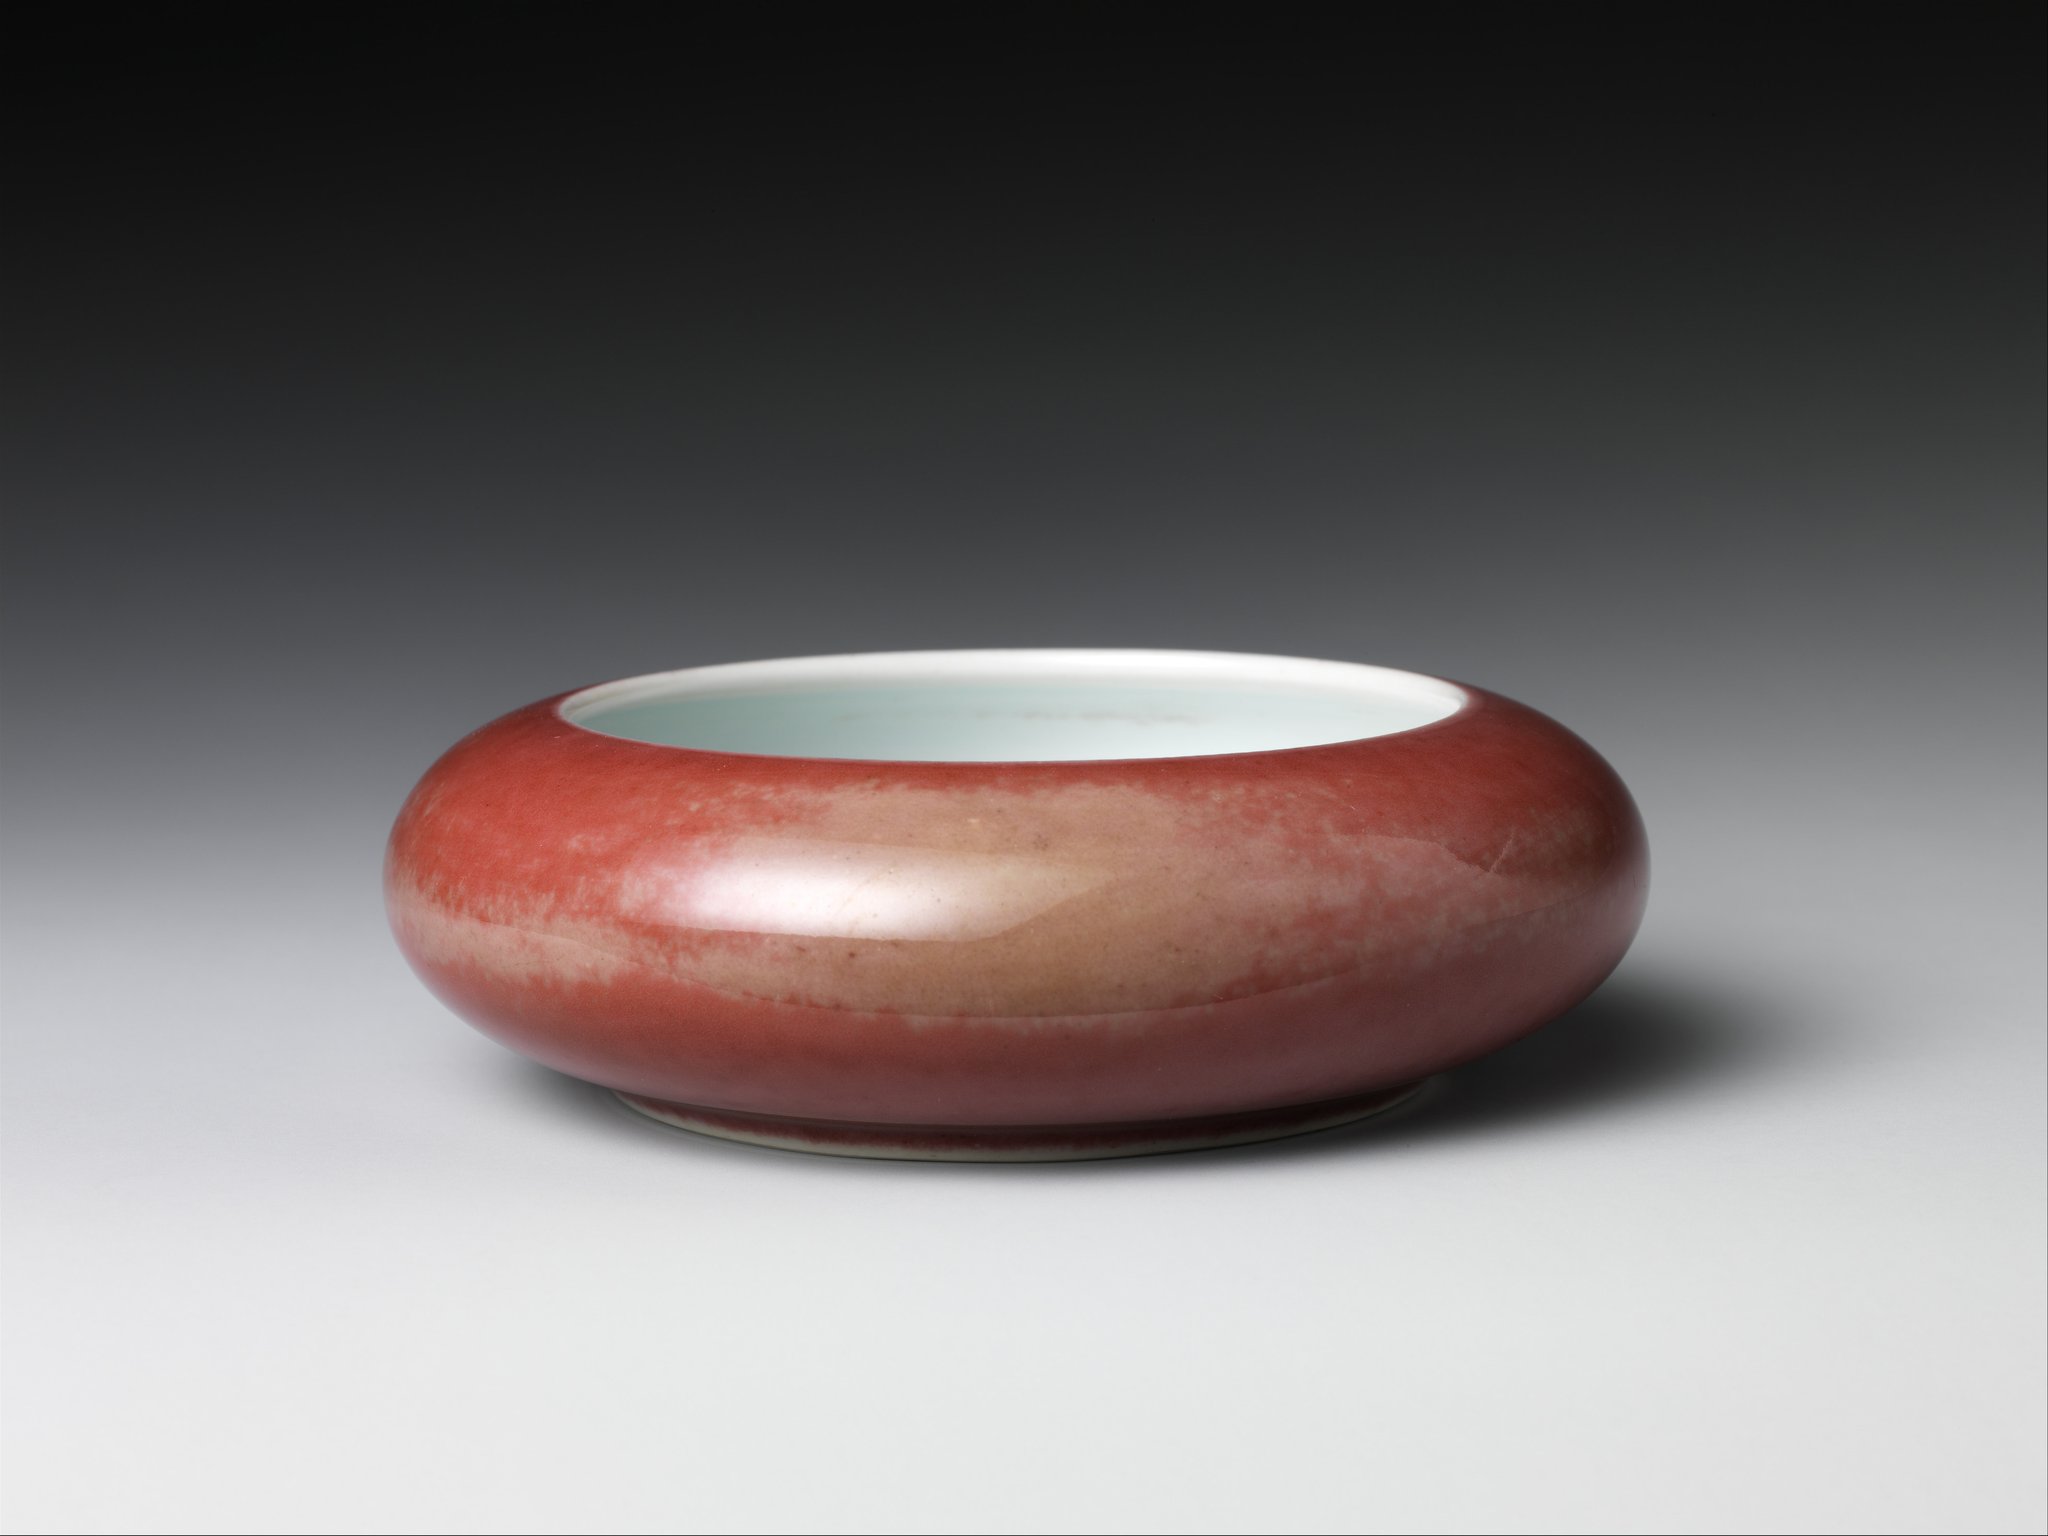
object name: brush washer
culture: chinese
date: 1662-1722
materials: glaze, porcelain